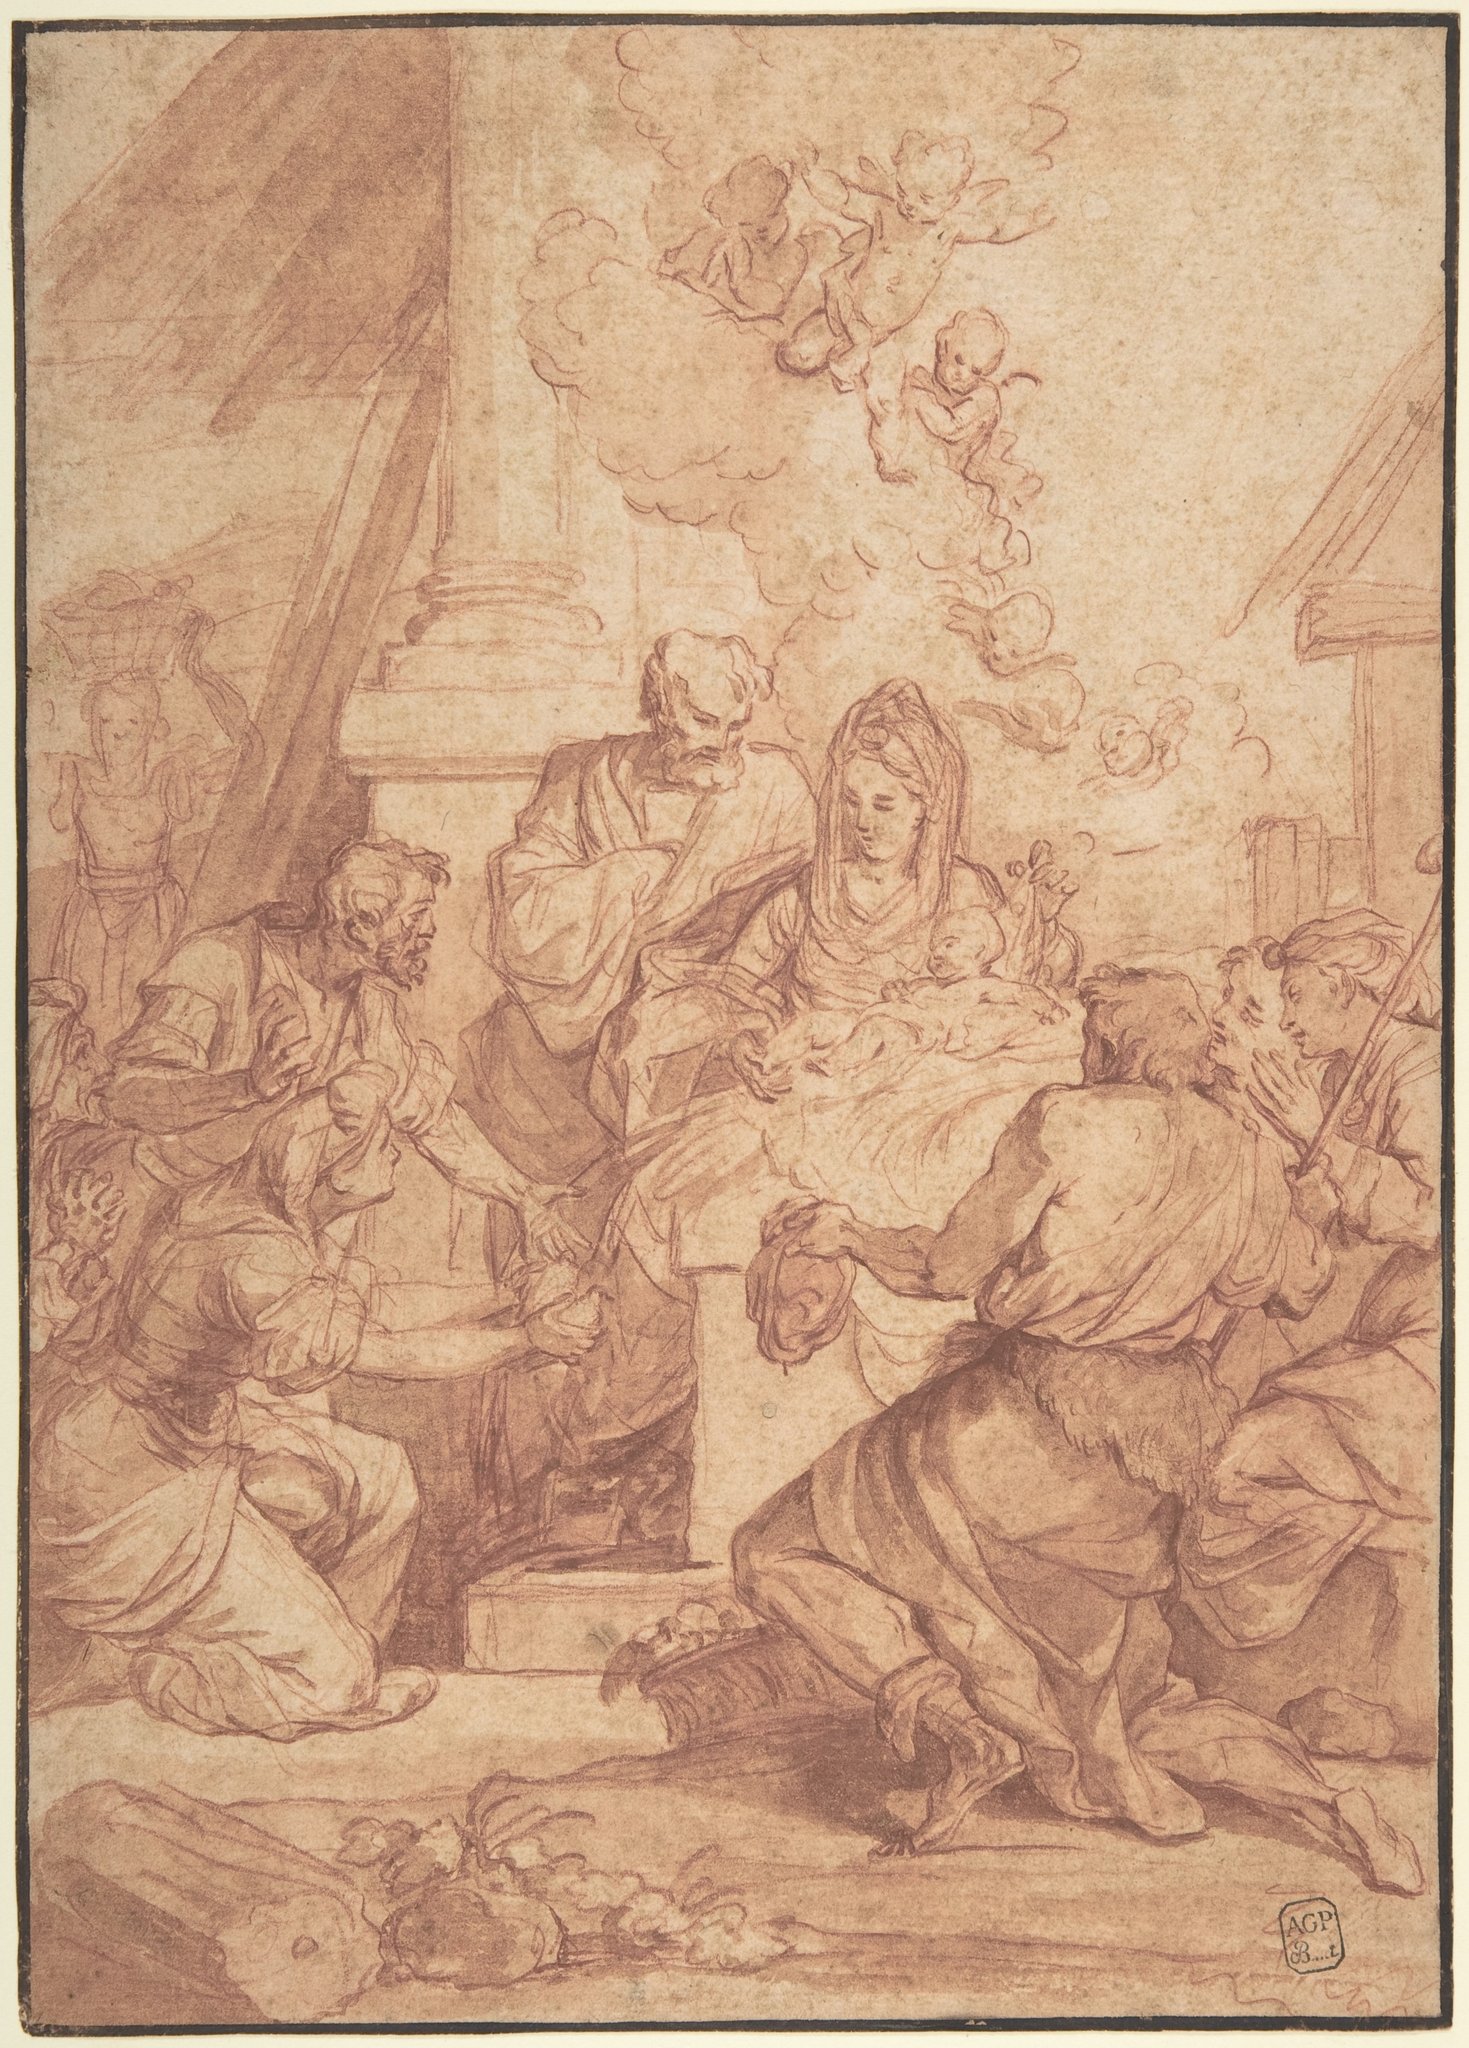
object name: drawing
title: Adoration of the Shepherds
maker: nicolas bertin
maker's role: painter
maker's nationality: french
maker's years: 1668-1736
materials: chalk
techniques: brush, wash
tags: virgin mary,jesus,adoration of the shepherds